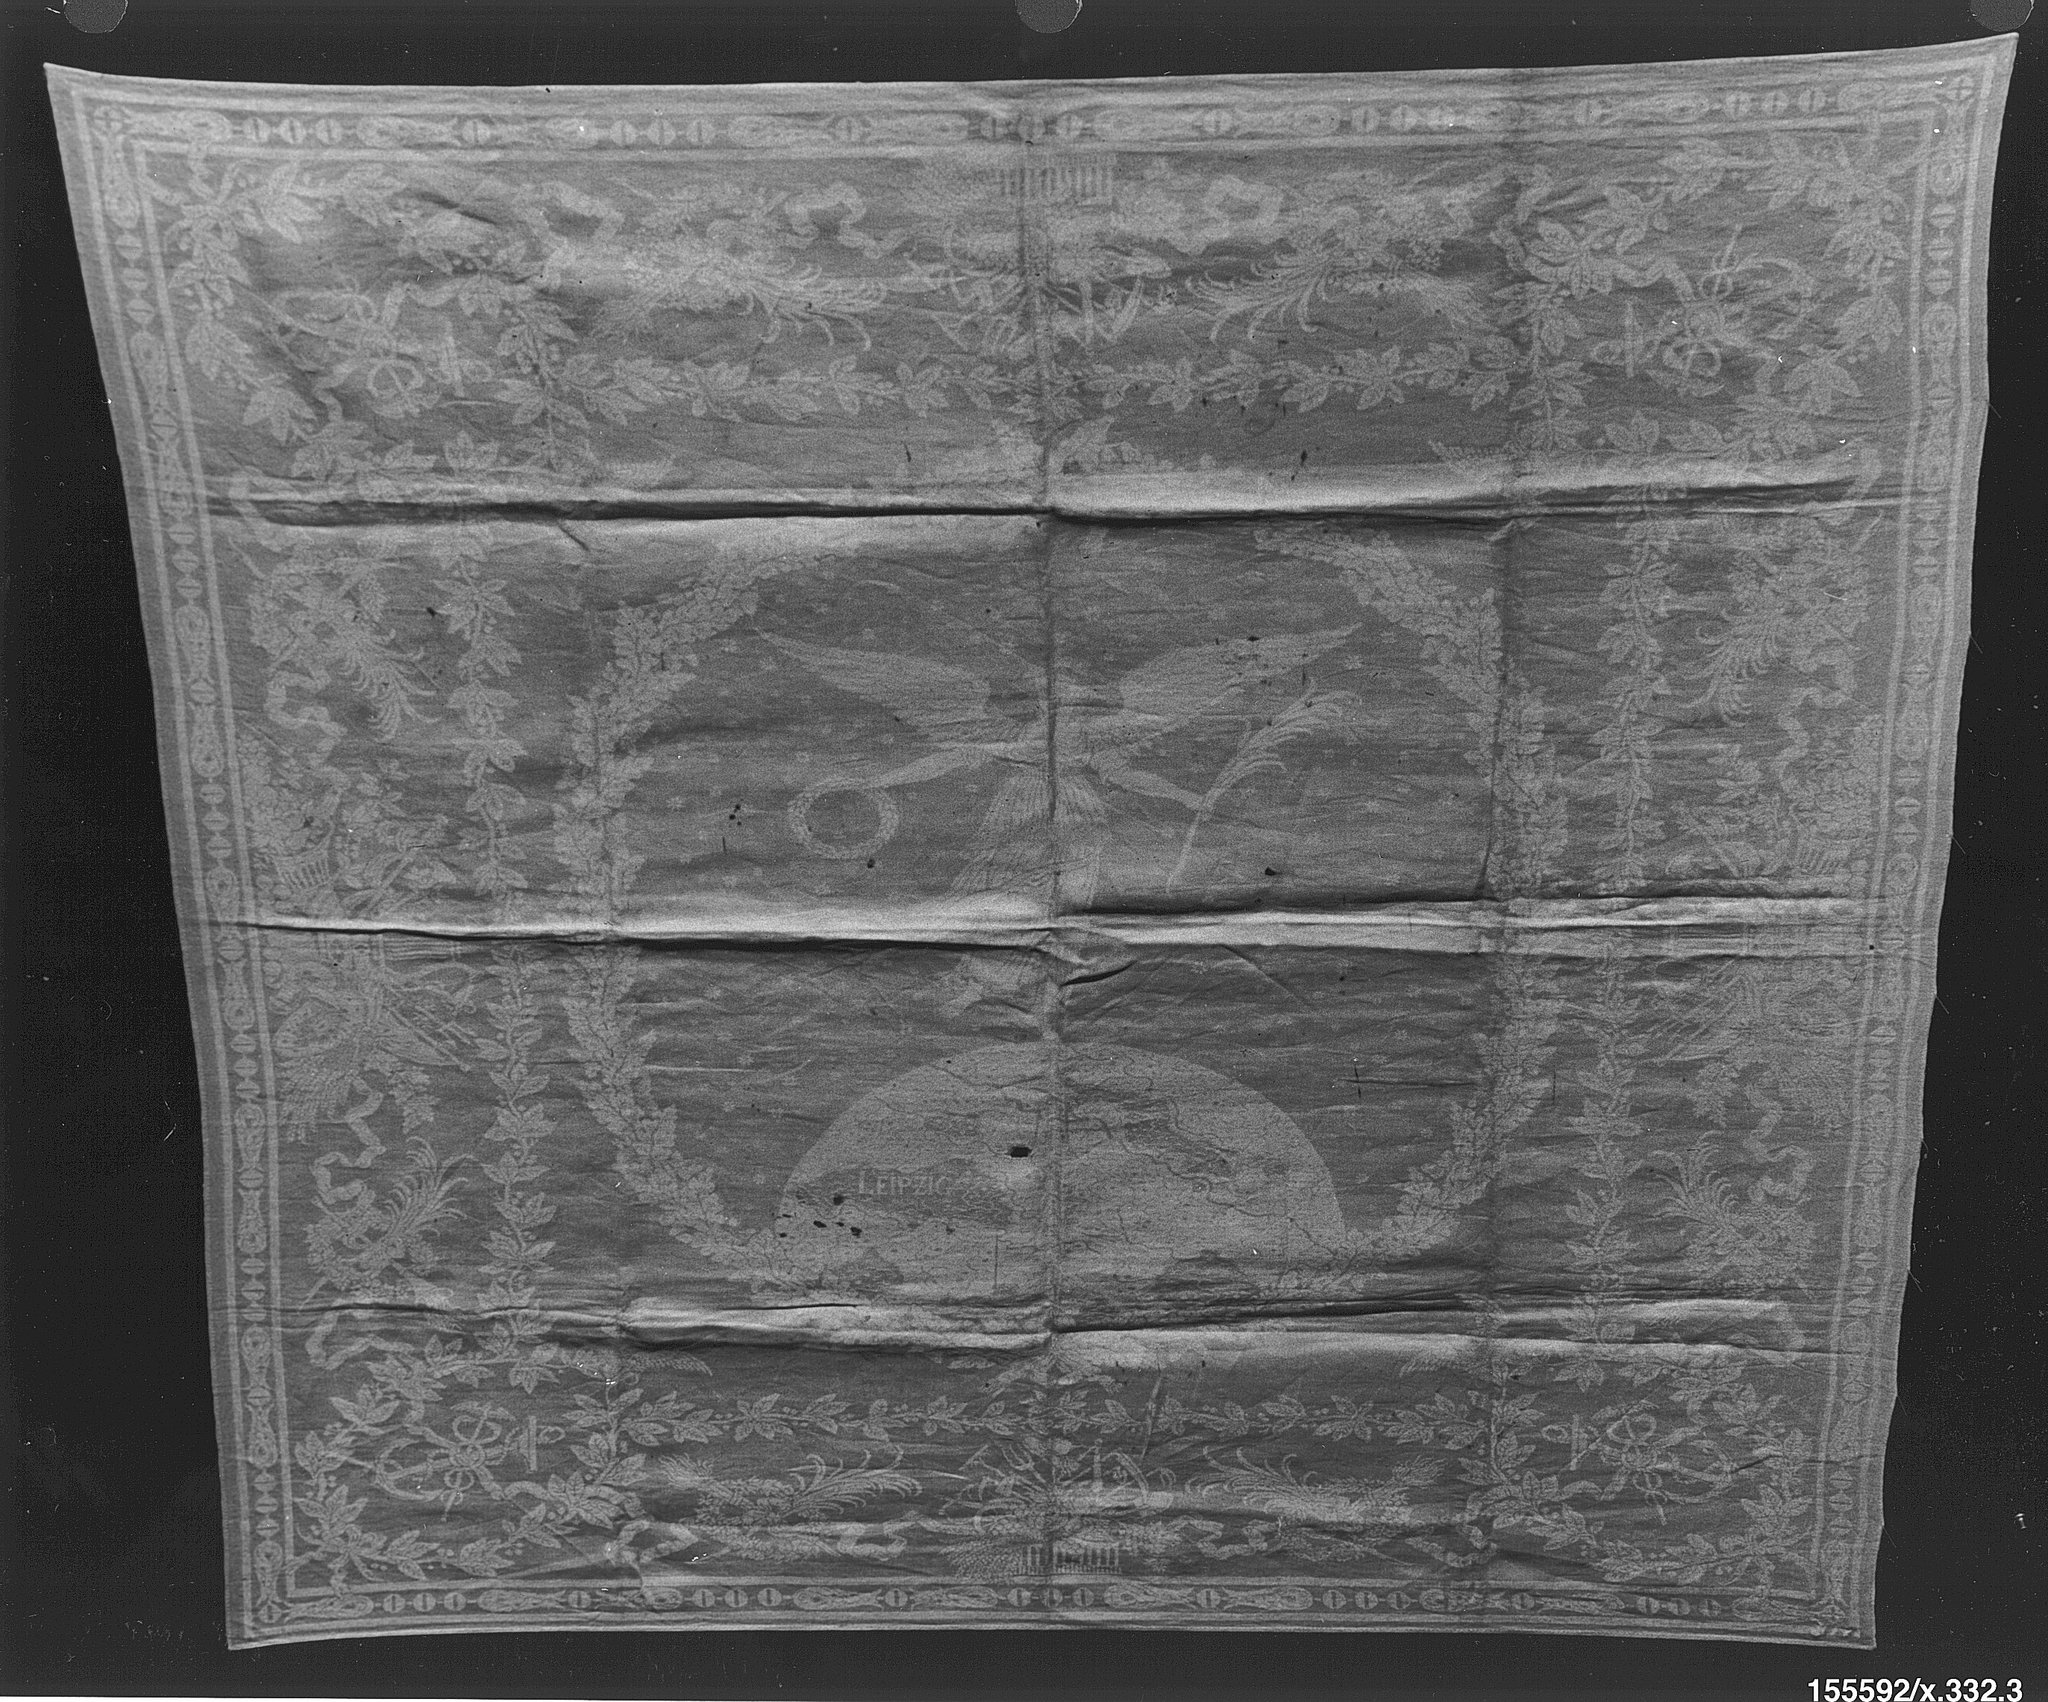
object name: tablecloth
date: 1815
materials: linen